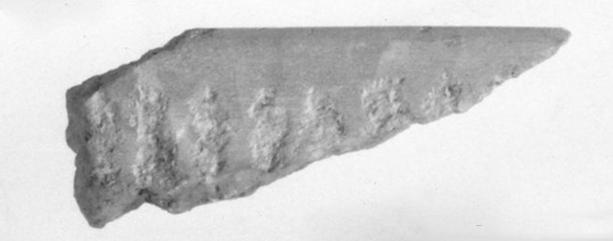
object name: canopic chest fragment, siptah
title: Canopic Chest Lid Fragment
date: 1194-1188 BCE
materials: stone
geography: egypt